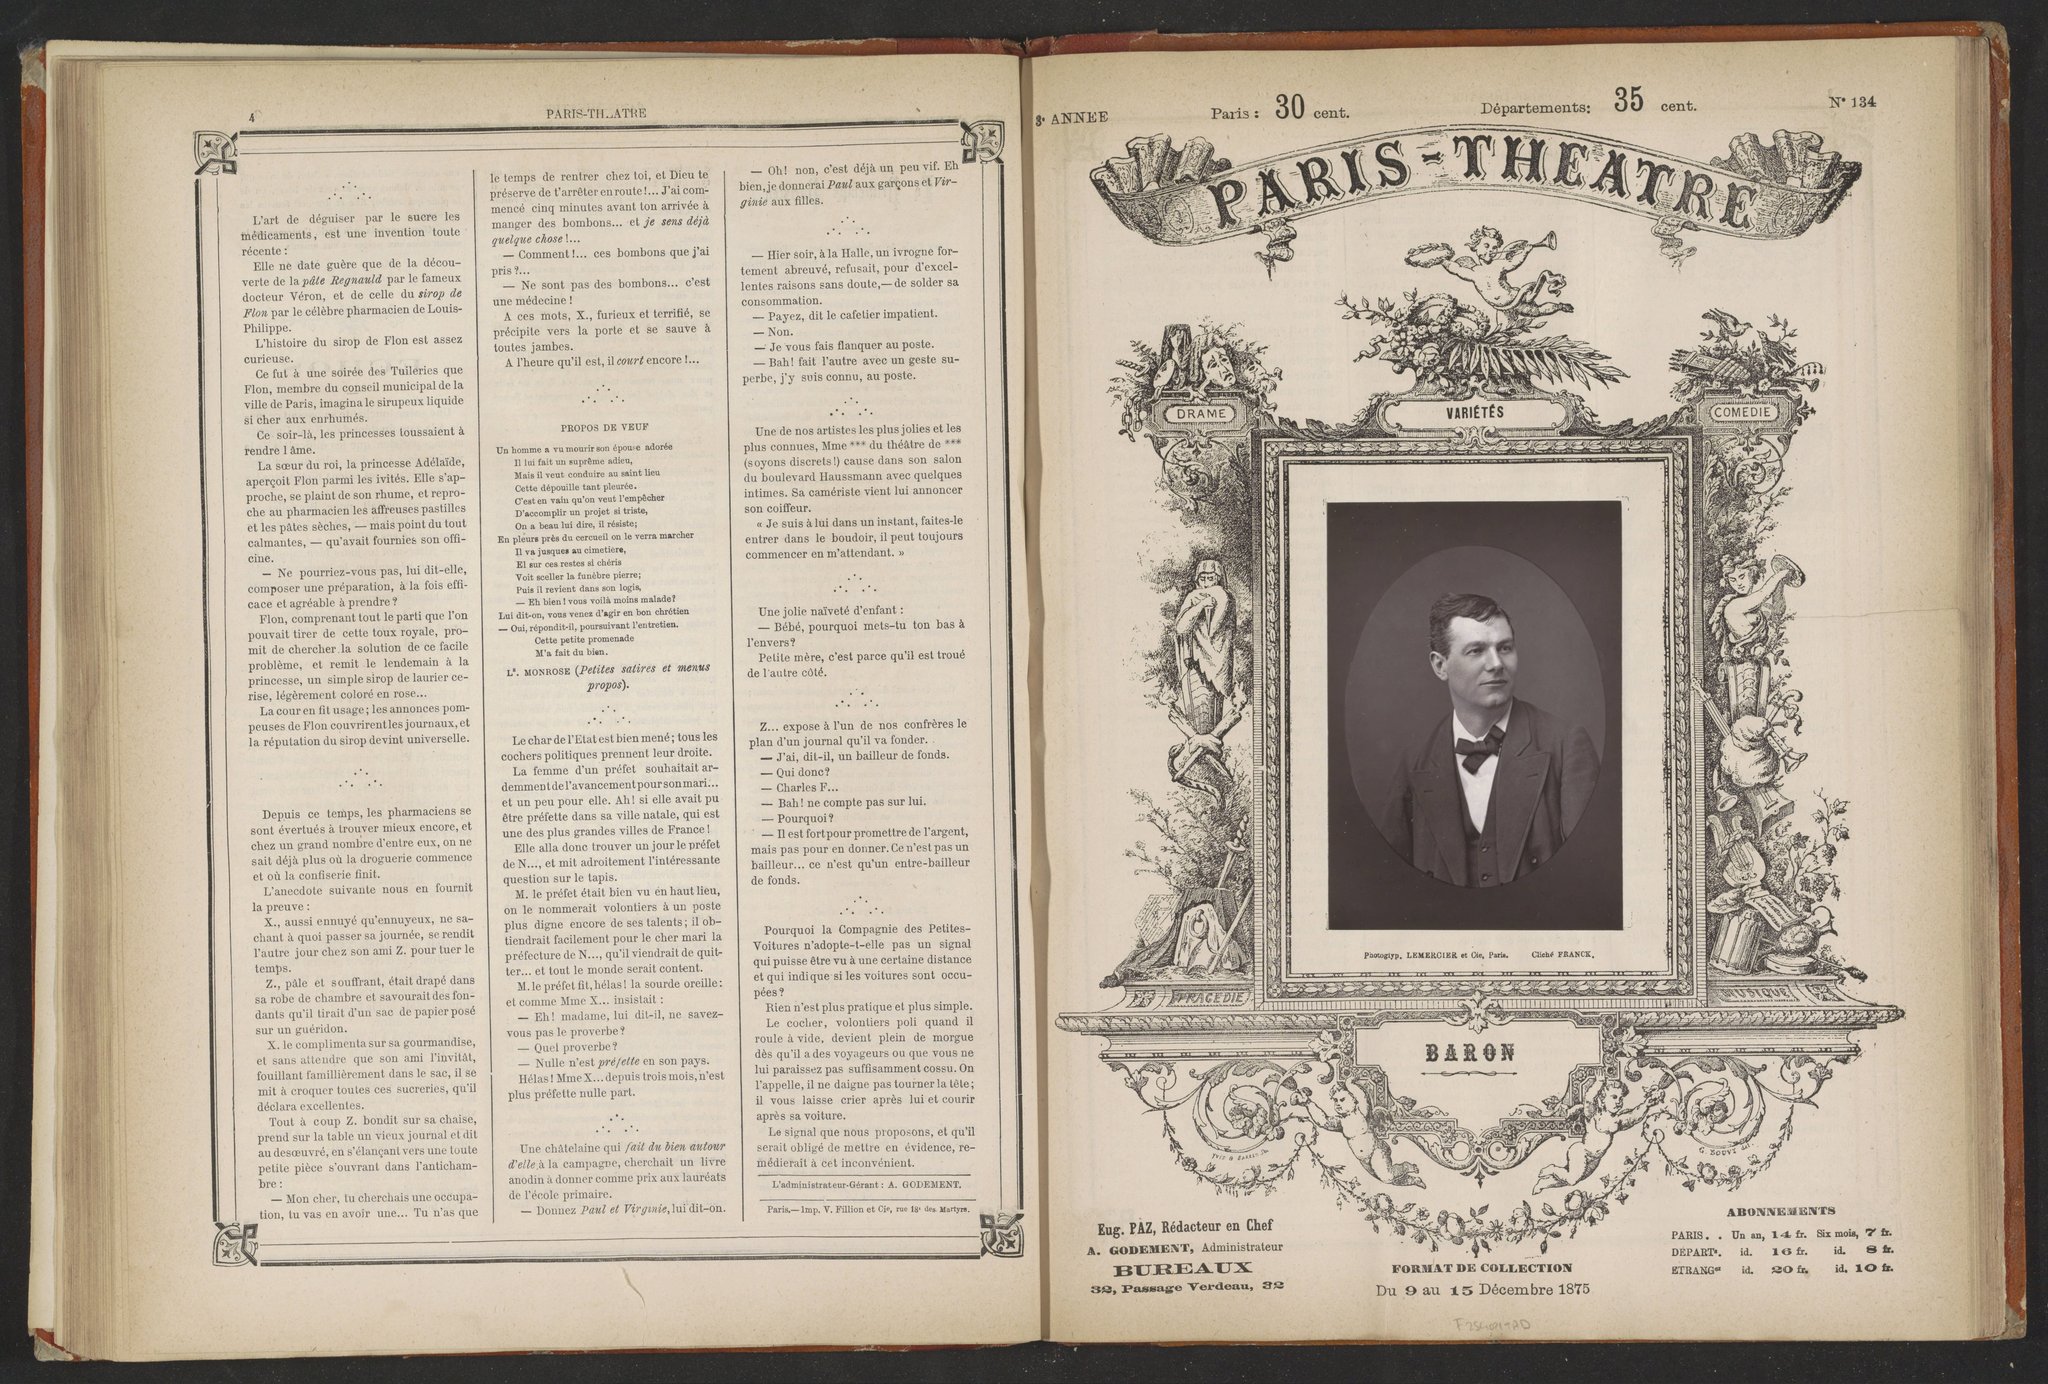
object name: page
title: Baron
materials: paper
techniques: woodburytype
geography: paris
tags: historical persons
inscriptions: number: ‘No 134’, inscription: ‘Du 19 au 15 Décembre 1875’